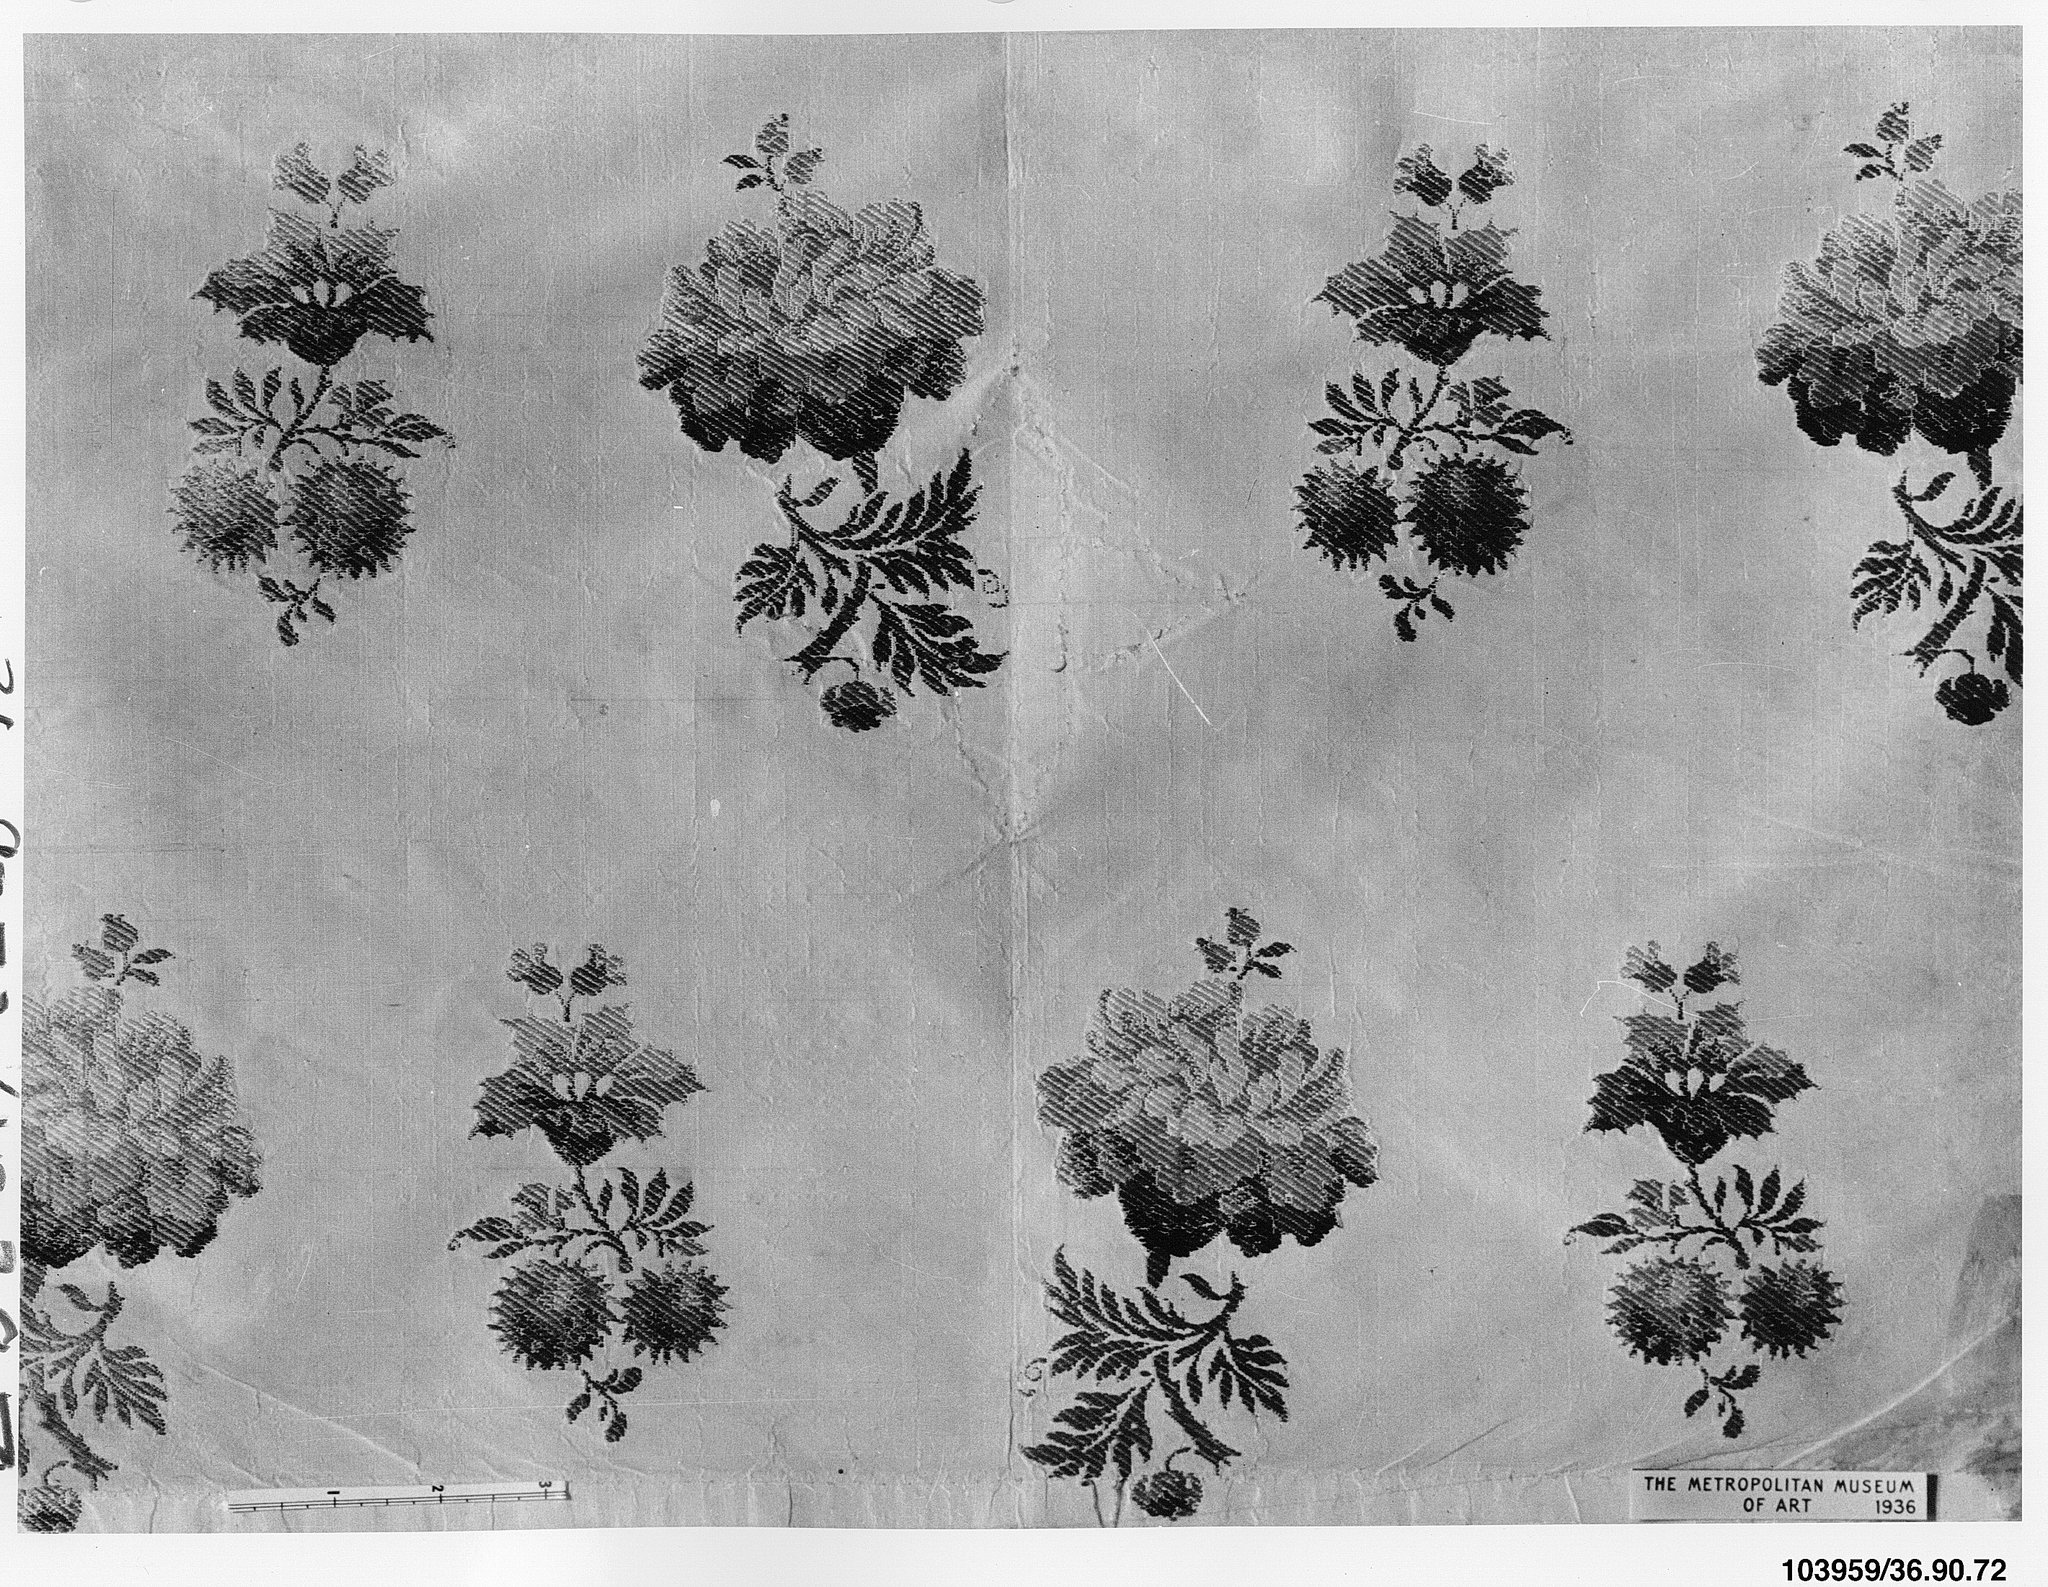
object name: piece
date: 1734-1766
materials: silk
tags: flowers